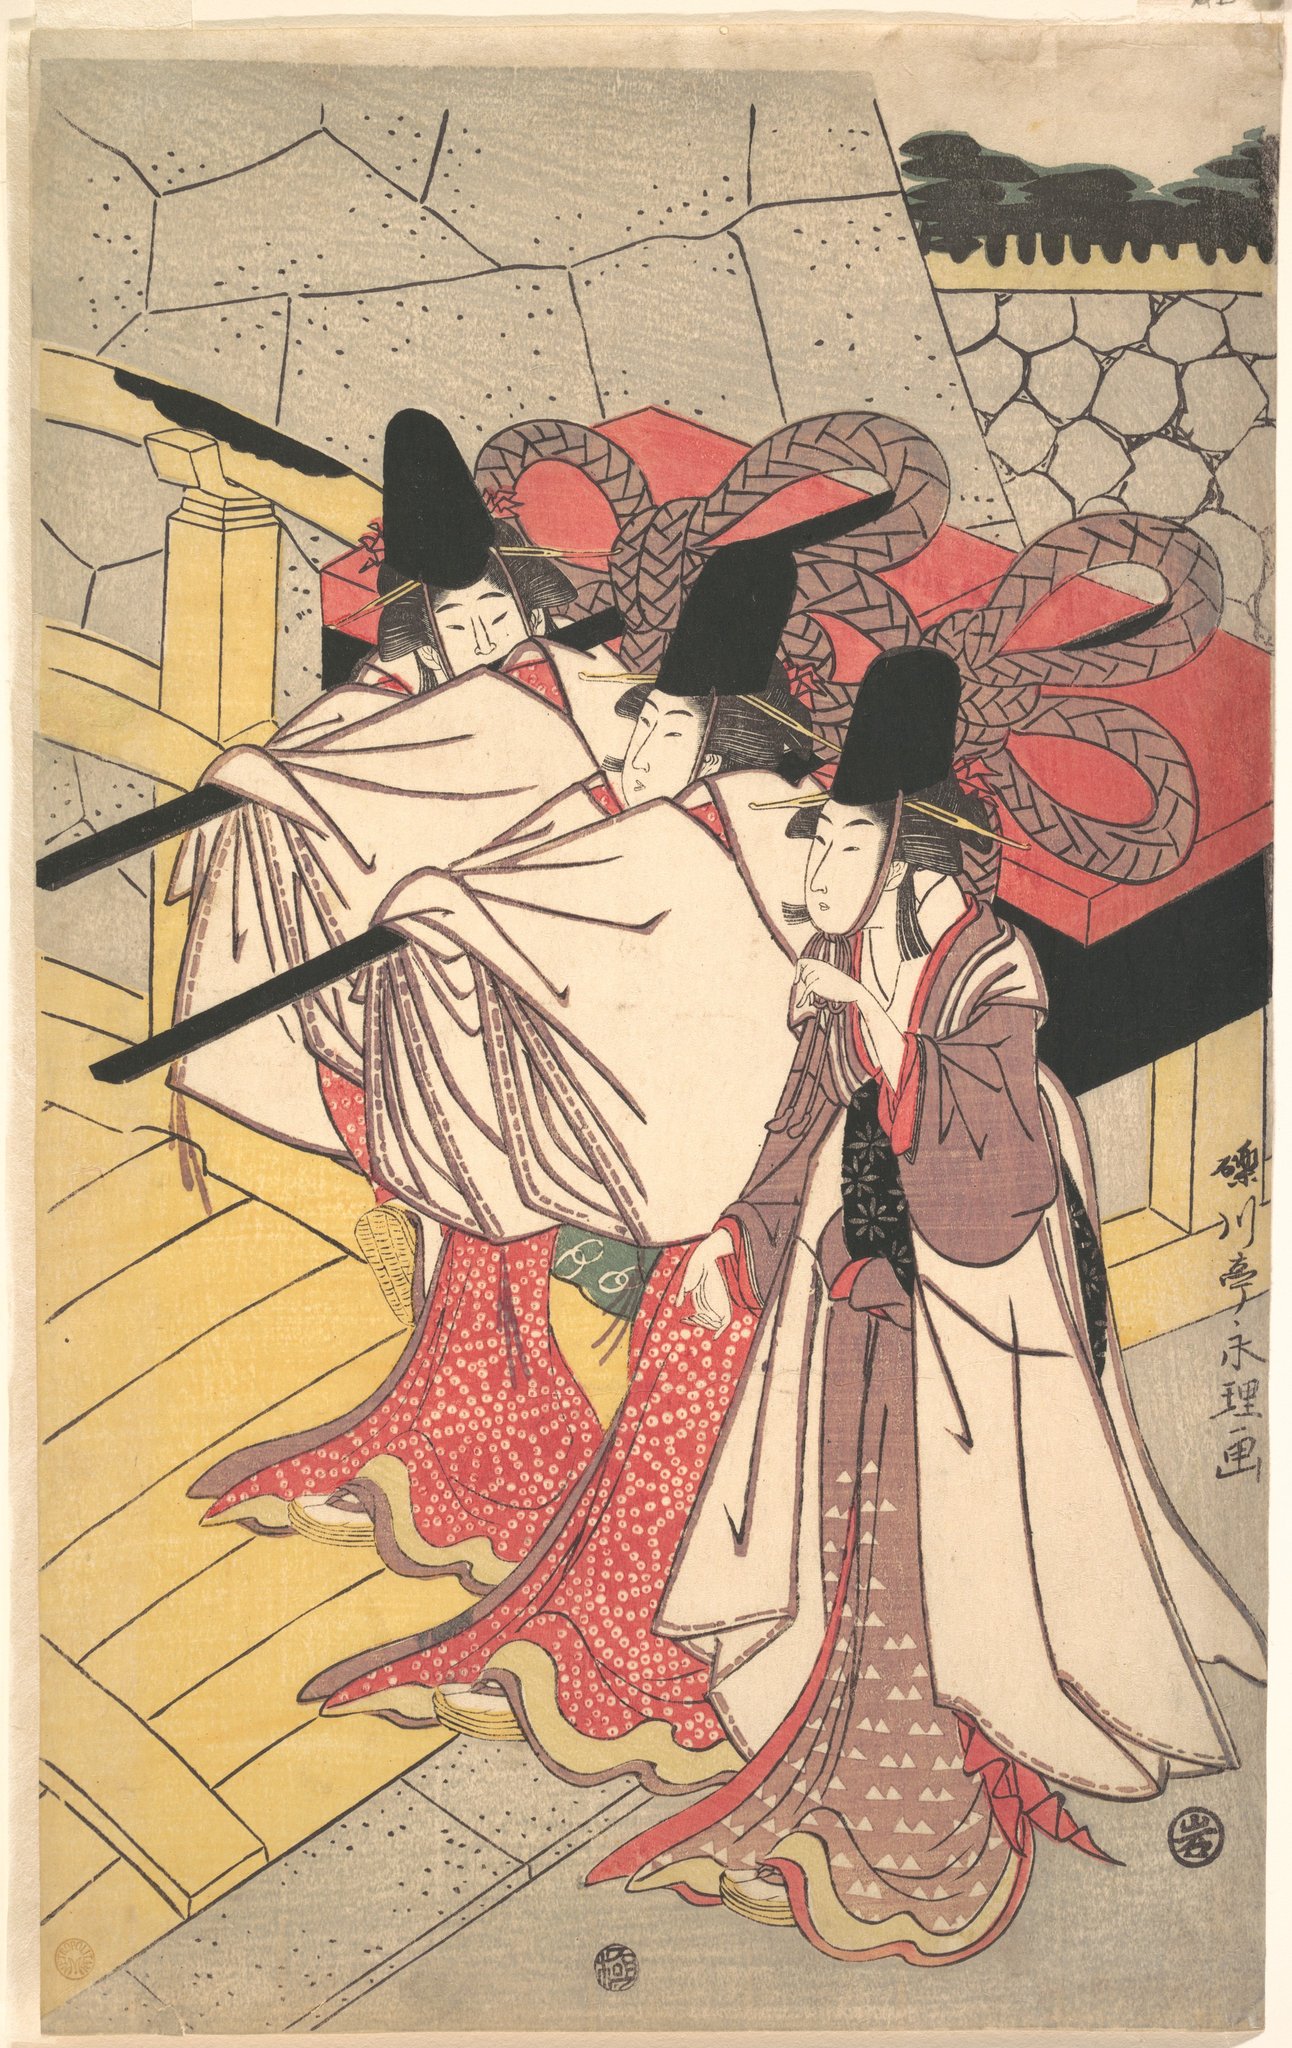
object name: print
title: Prince Genji Returning to His Palace where His Wife Awaits Him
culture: japanese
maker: rekisentei eiri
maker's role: artist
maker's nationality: japanese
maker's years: 1789-1801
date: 1797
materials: ink, paper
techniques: woodblock print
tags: men,women,horses